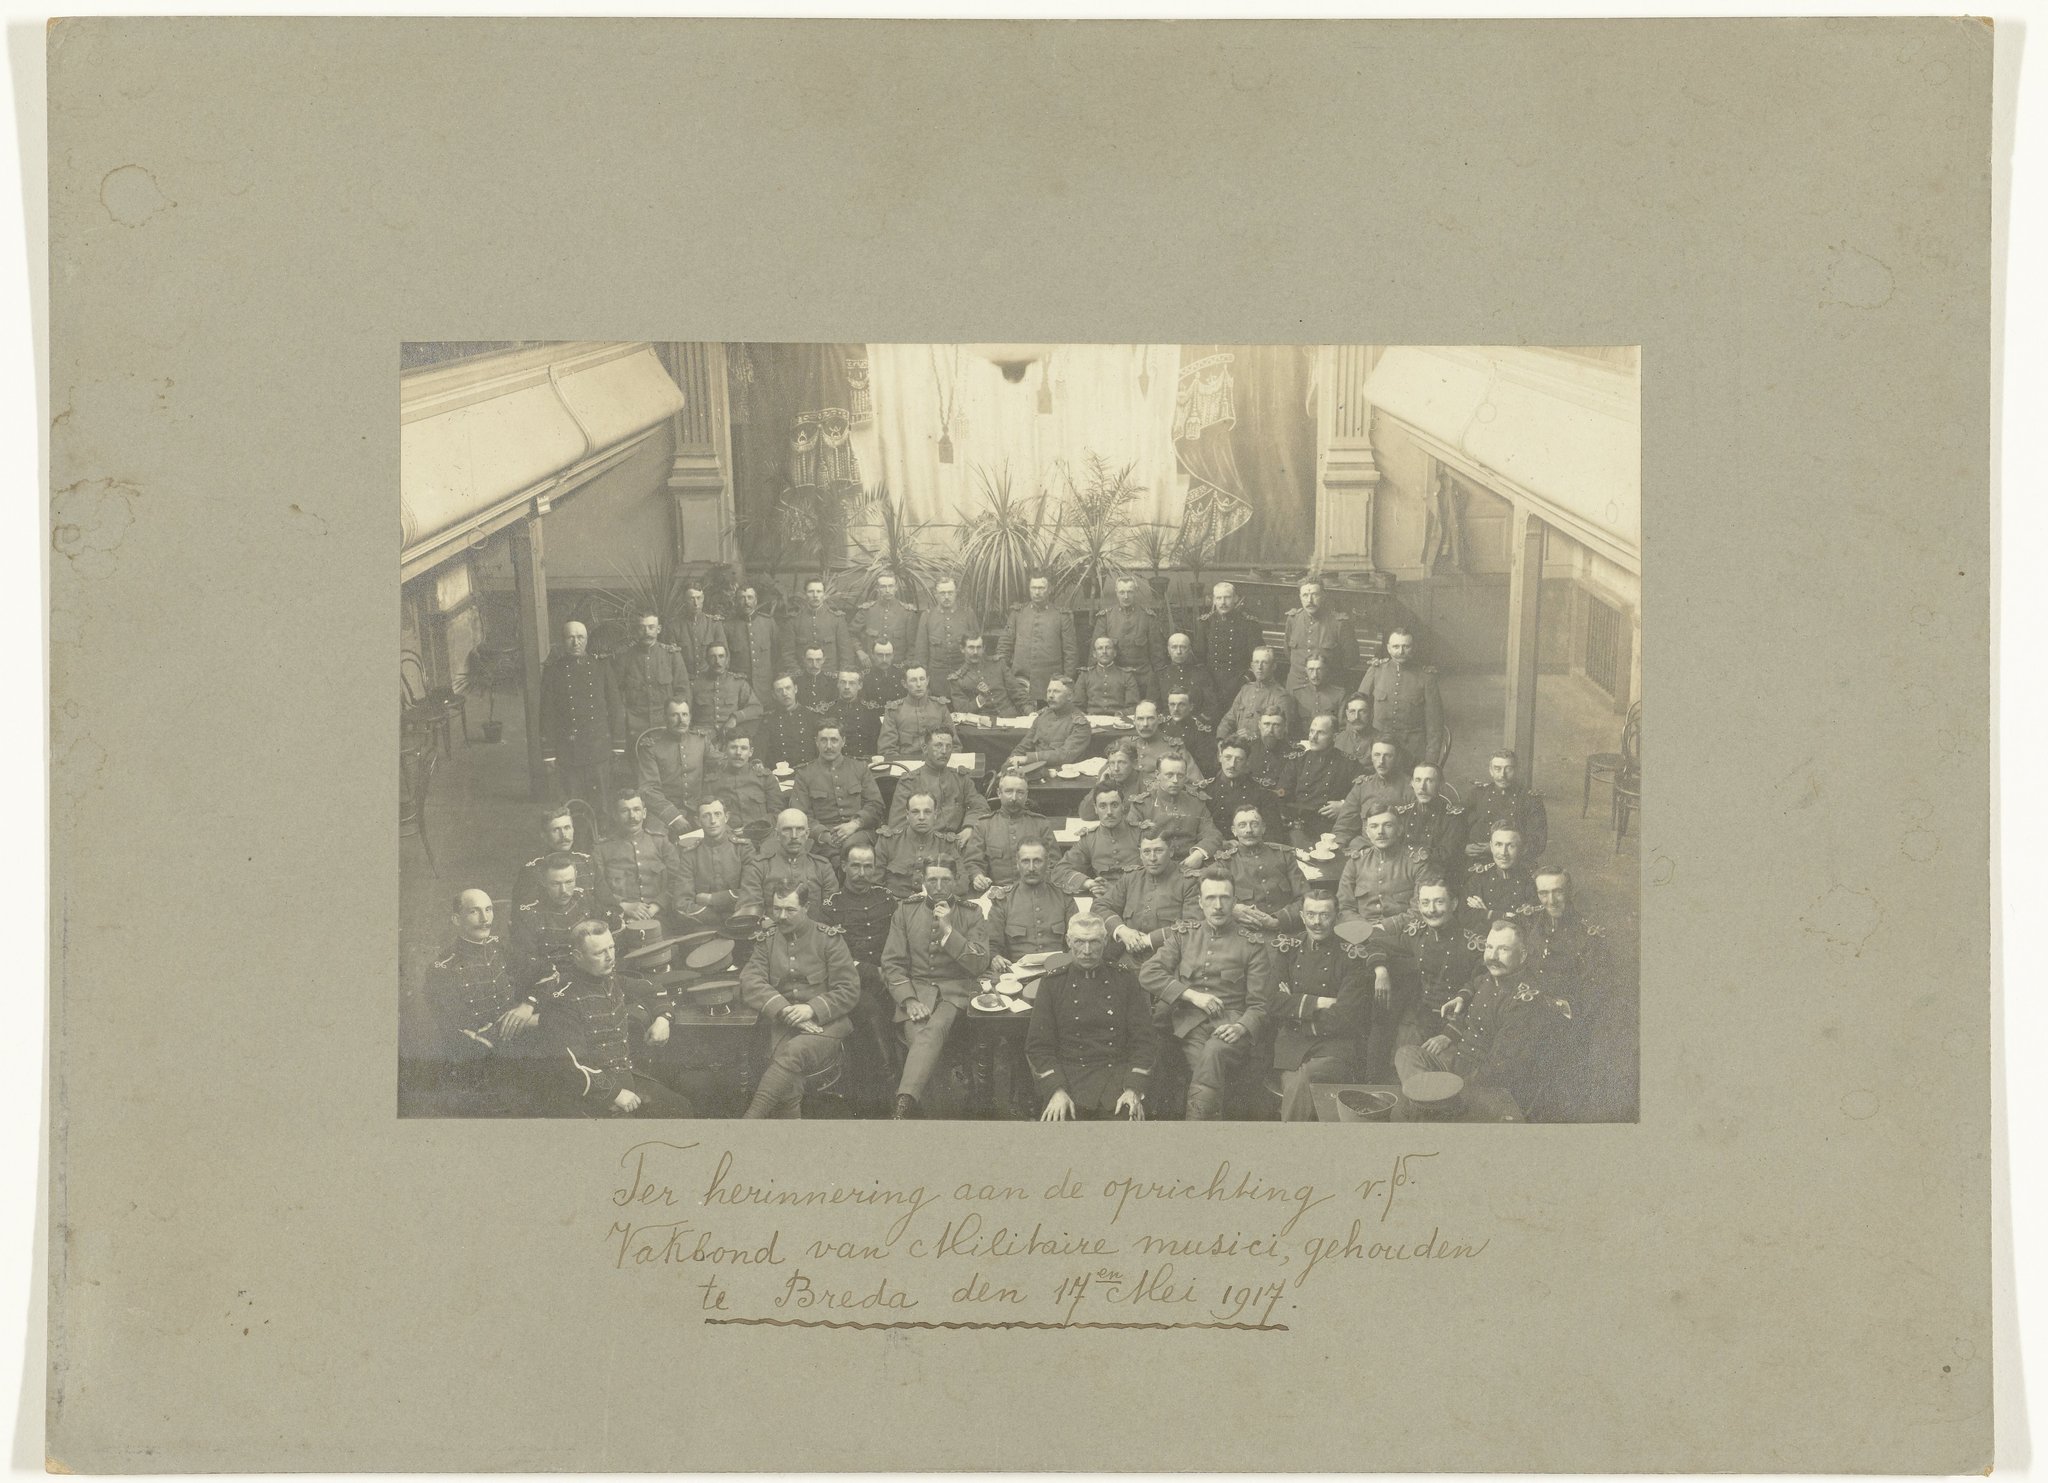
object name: photograph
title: Groepsportret van de Vakbond van Militaire musici, Breda, 1917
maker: Anonymous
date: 1917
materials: cardboard, photographic support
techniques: gelatin silver print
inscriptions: annotation: ‘Ter herinnering aan de oprichting v./d.//Vakbond van Militaire musici, gehouden//te Breda den 17en Mei 1917’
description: Groepsportret in (kerk?-) interieur ter gelegenheid van de oprichting van de Vakbond van Miliataire musici, Breda, 1917. De mannen zitten in uniform aan tafels te poseren voor de foto, die van boven is genomen.